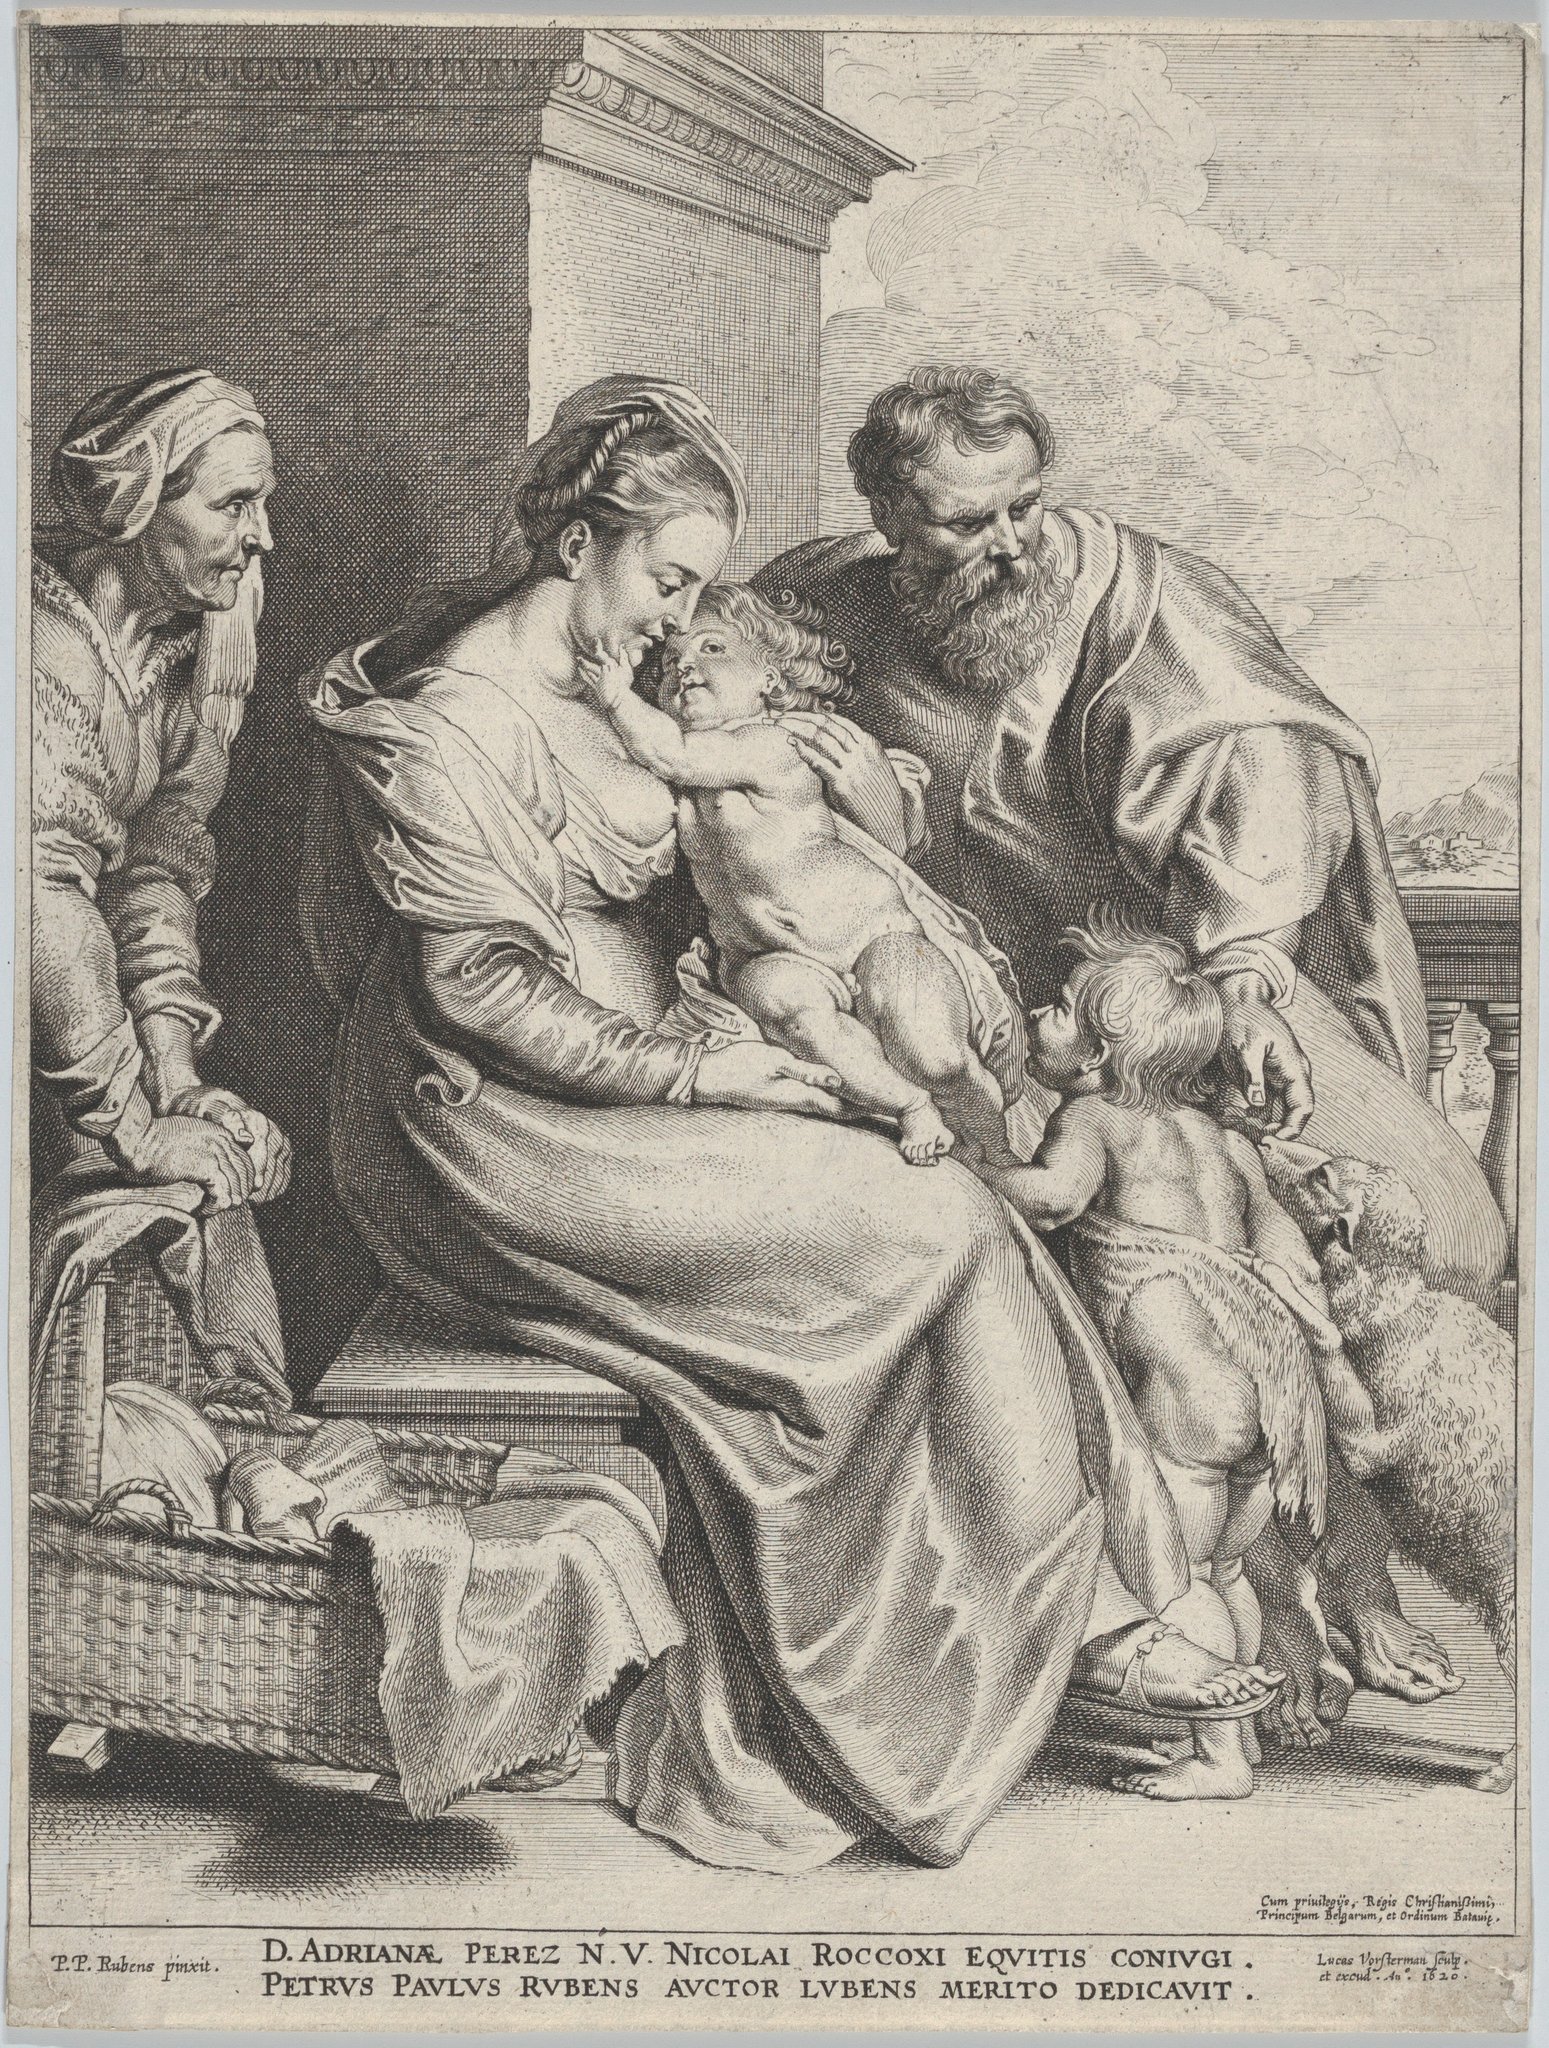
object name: print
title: The Holy Family with Saint Elizabeth and John the Baptist as a Child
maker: lucas vorsterman (i)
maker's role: artist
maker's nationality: flemish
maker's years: 1595-1675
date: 1620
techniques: engraving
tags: christ,holy family,saint john the baptist,virgin mary,saints